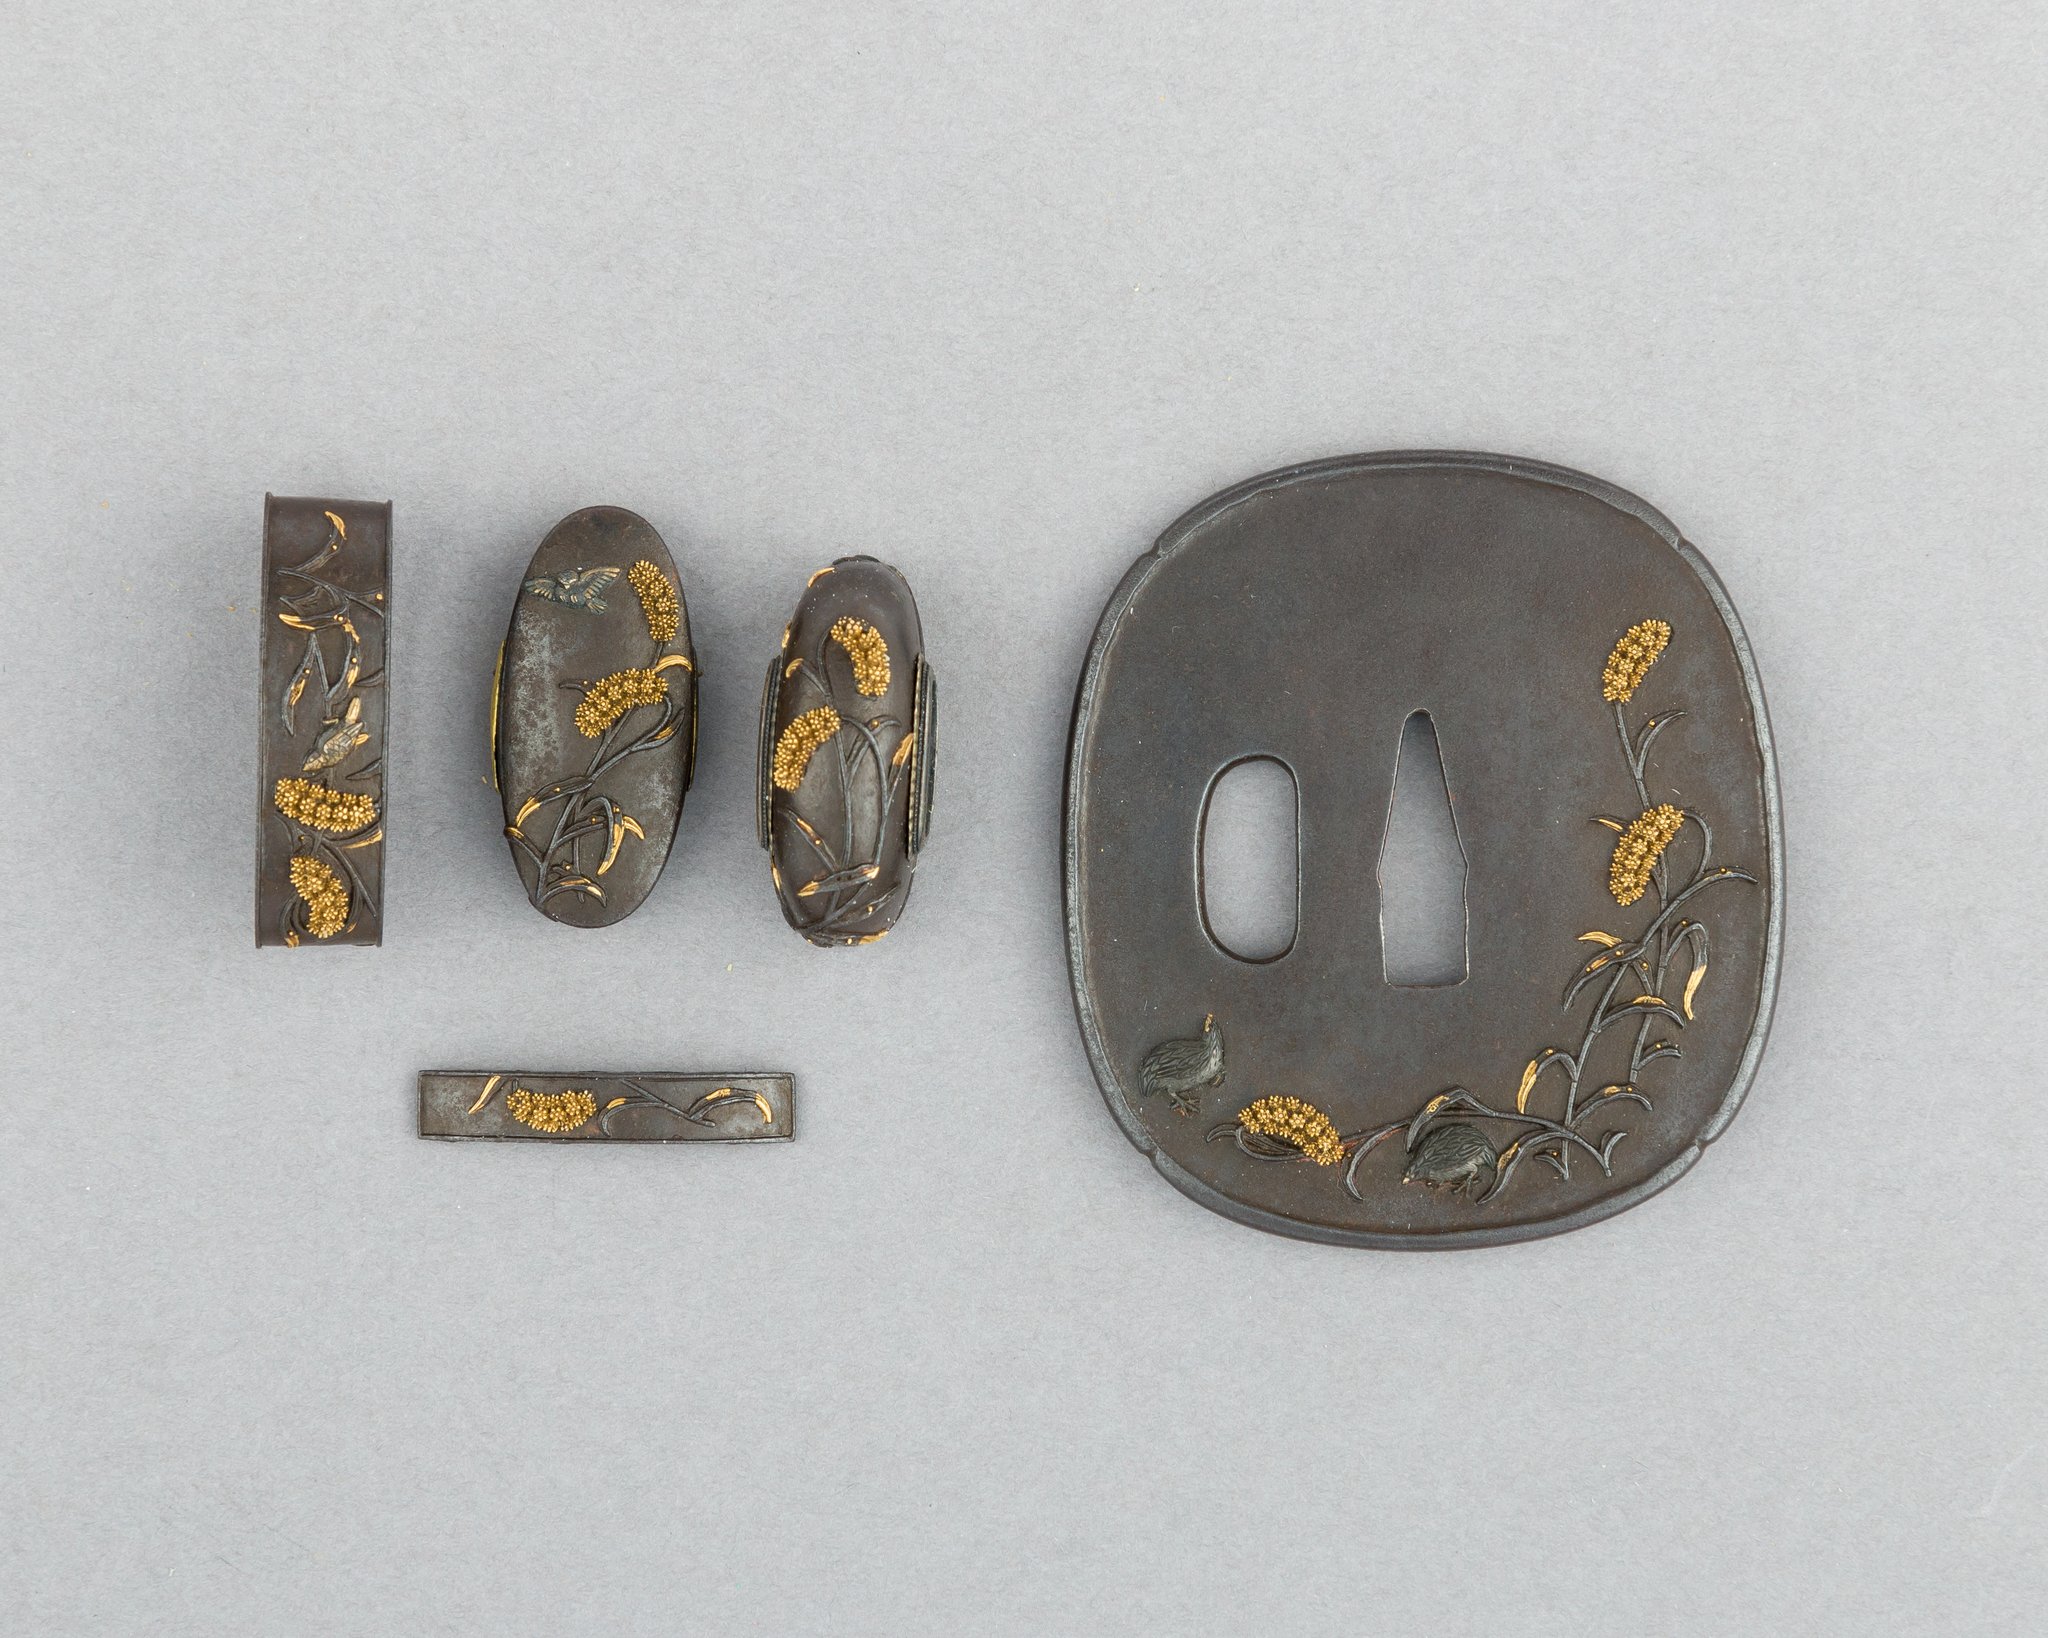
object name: set of sword fitting mitokoromono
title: Set of Sword Fittings (Mitokoromono)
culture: japanese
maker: ginshōtei tōmei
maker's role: fittings maker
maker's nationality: japanese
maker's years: 1817-1870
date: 1801-1900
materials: silver alloy, gold, iron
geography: japan